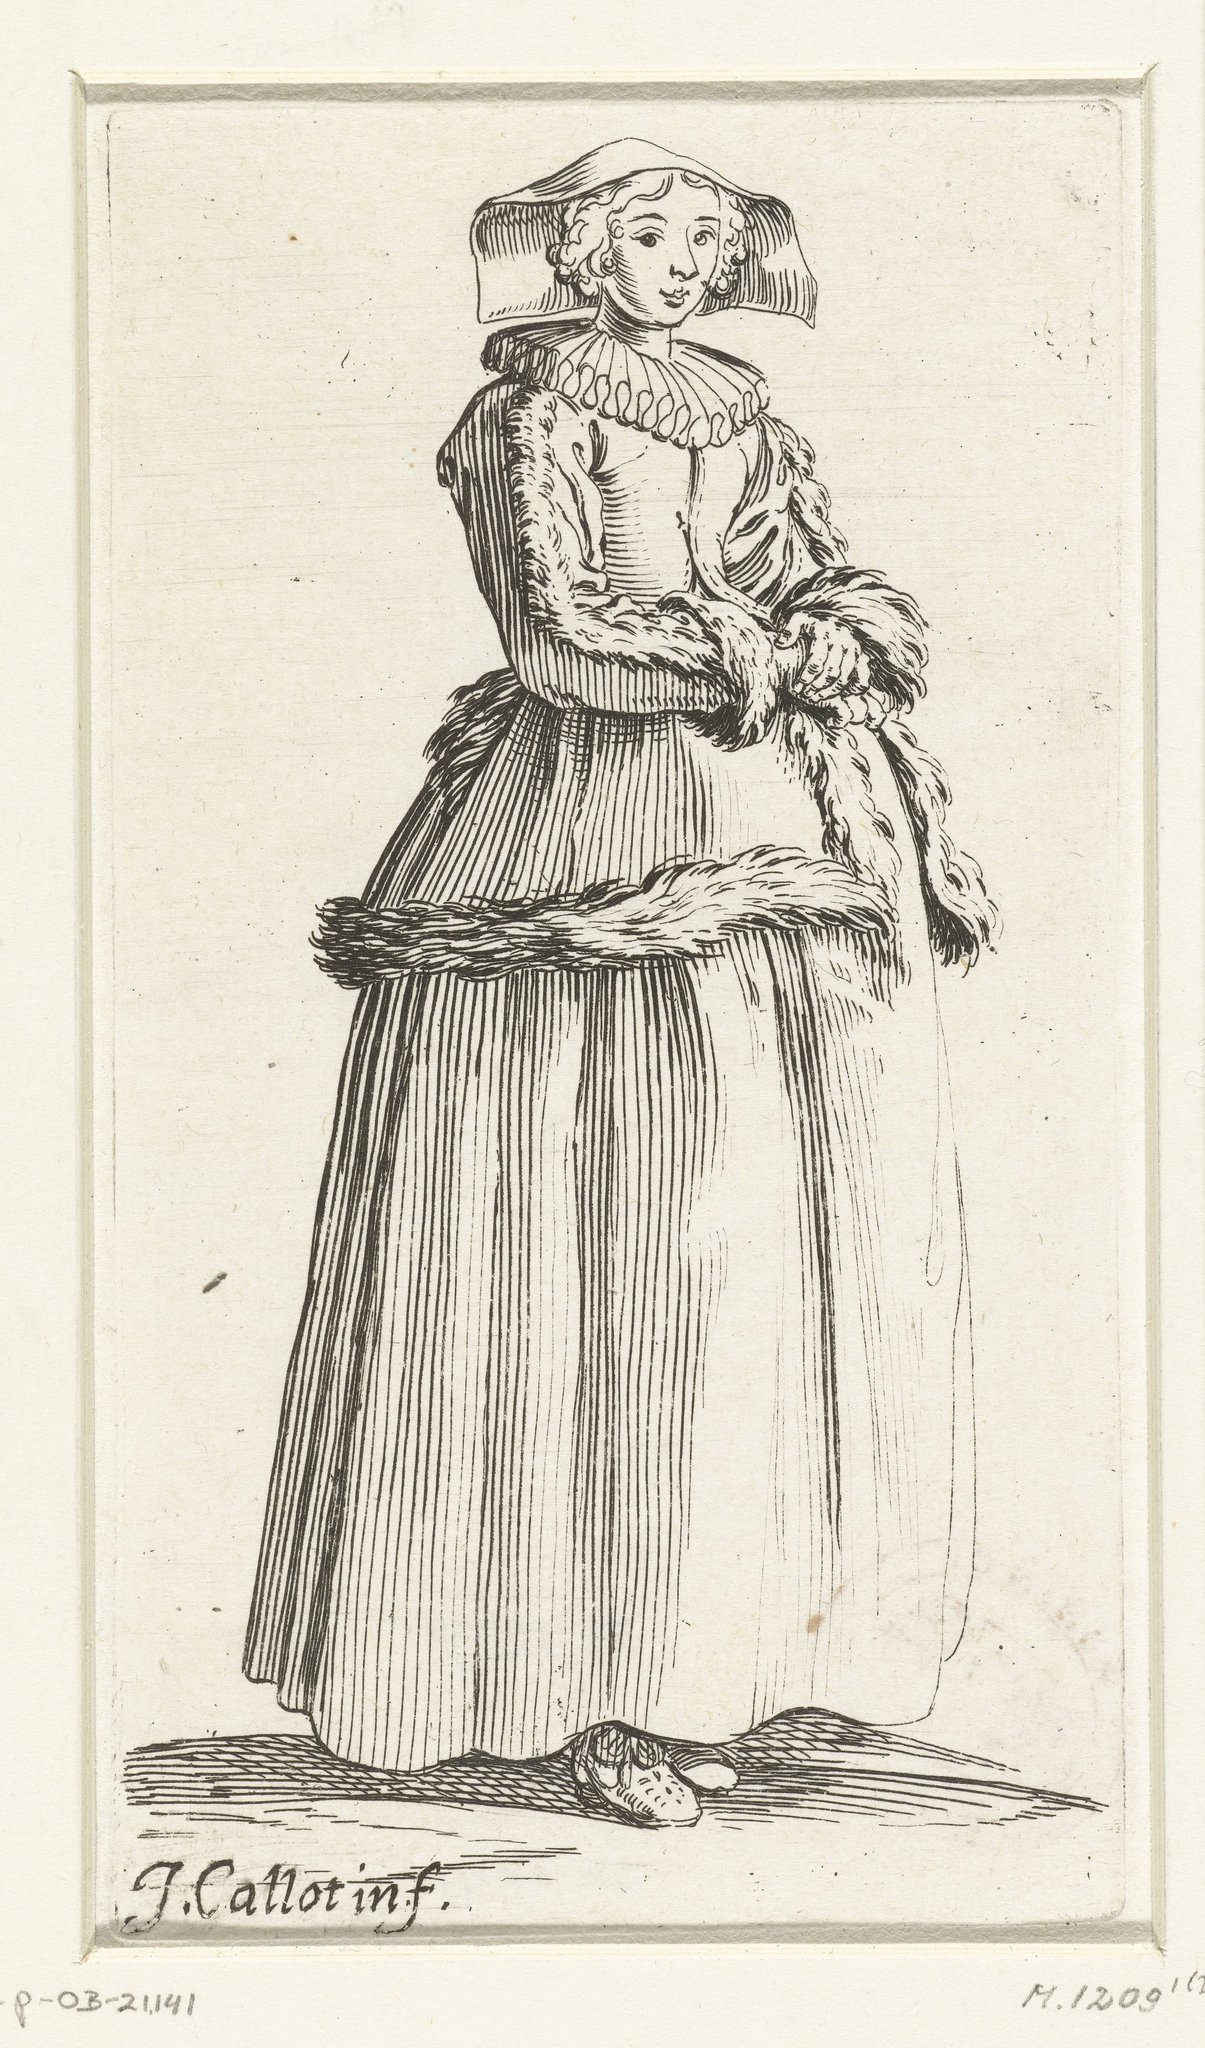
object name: costume print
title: Vrouw met bontmantel, de handen voor de buik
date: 1630-1661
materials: paper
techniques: etching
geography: paris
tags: dress, gown (+ women's clothes), france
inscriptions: collector's mark: Lugt 240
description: Vrouw, ten voeten uit, op de rechterzijde gezien, de handen voor de buik, gehuld in Franse burgerlijke kleding zoals die gedragen werd rond 1625.